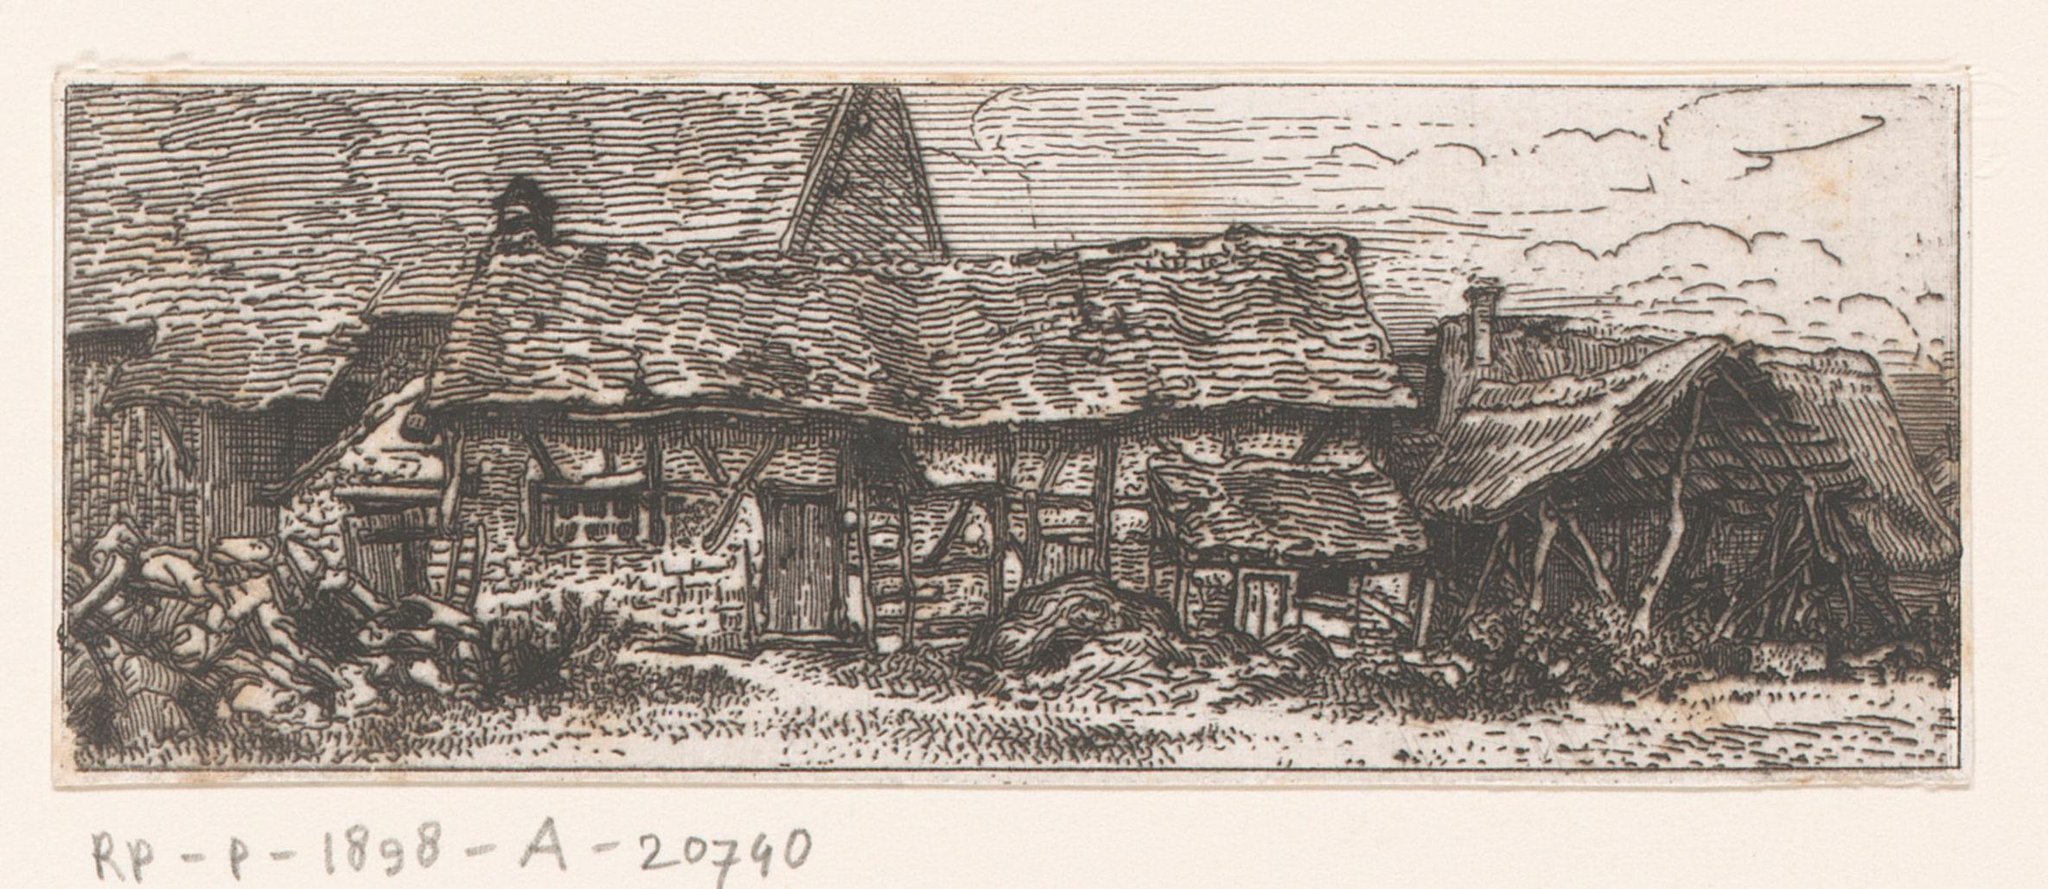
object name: print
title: Gezicht op boerenwoningen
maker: charles emile jacque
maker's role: draughtsman, painter, print maker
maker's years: 1813-1894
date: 1843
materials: paper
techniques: etching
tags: rural housing, e.g. country-house, villa, cottage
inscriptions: collector's mark: Lugt 964